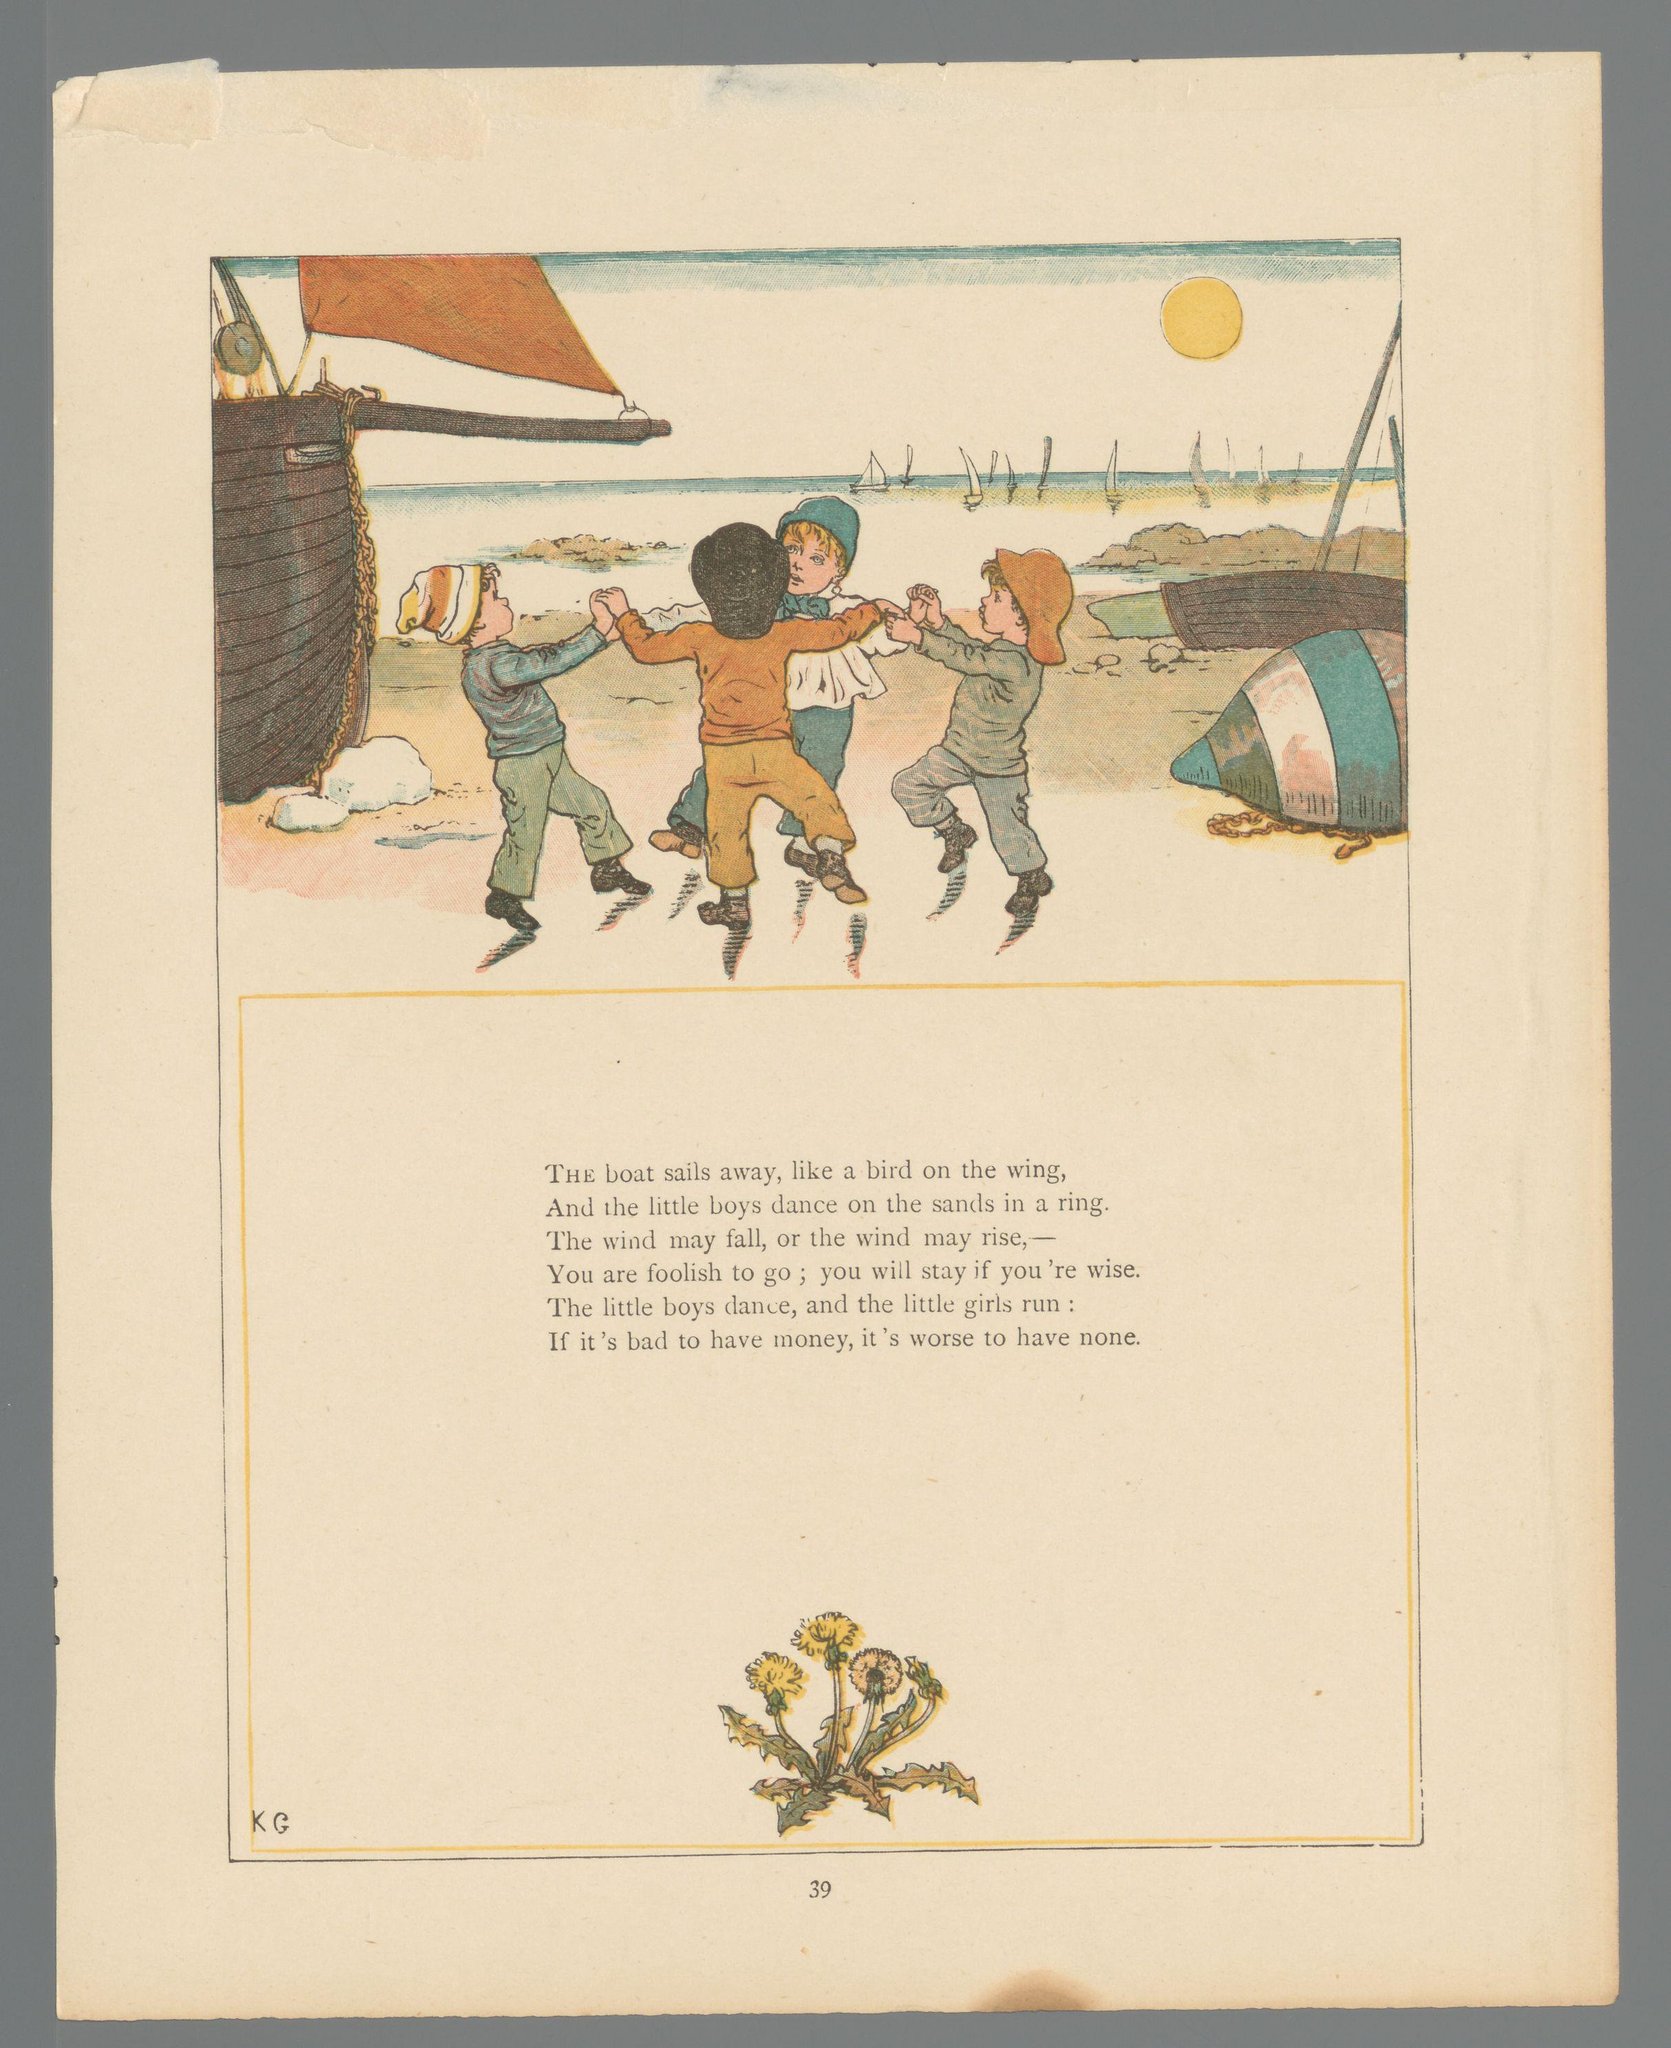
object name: book illustration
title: Vier kinderen dansen op het strand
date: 1878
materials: paper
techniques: wood engraving, letterpress printing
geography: london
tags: child (+ four persons), group dancing, beach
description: Prent uit: Greenaway, Kate. Under the window, pictures & rhymes for children. Londen: George Routledge & Sons, 1878, p. 39.